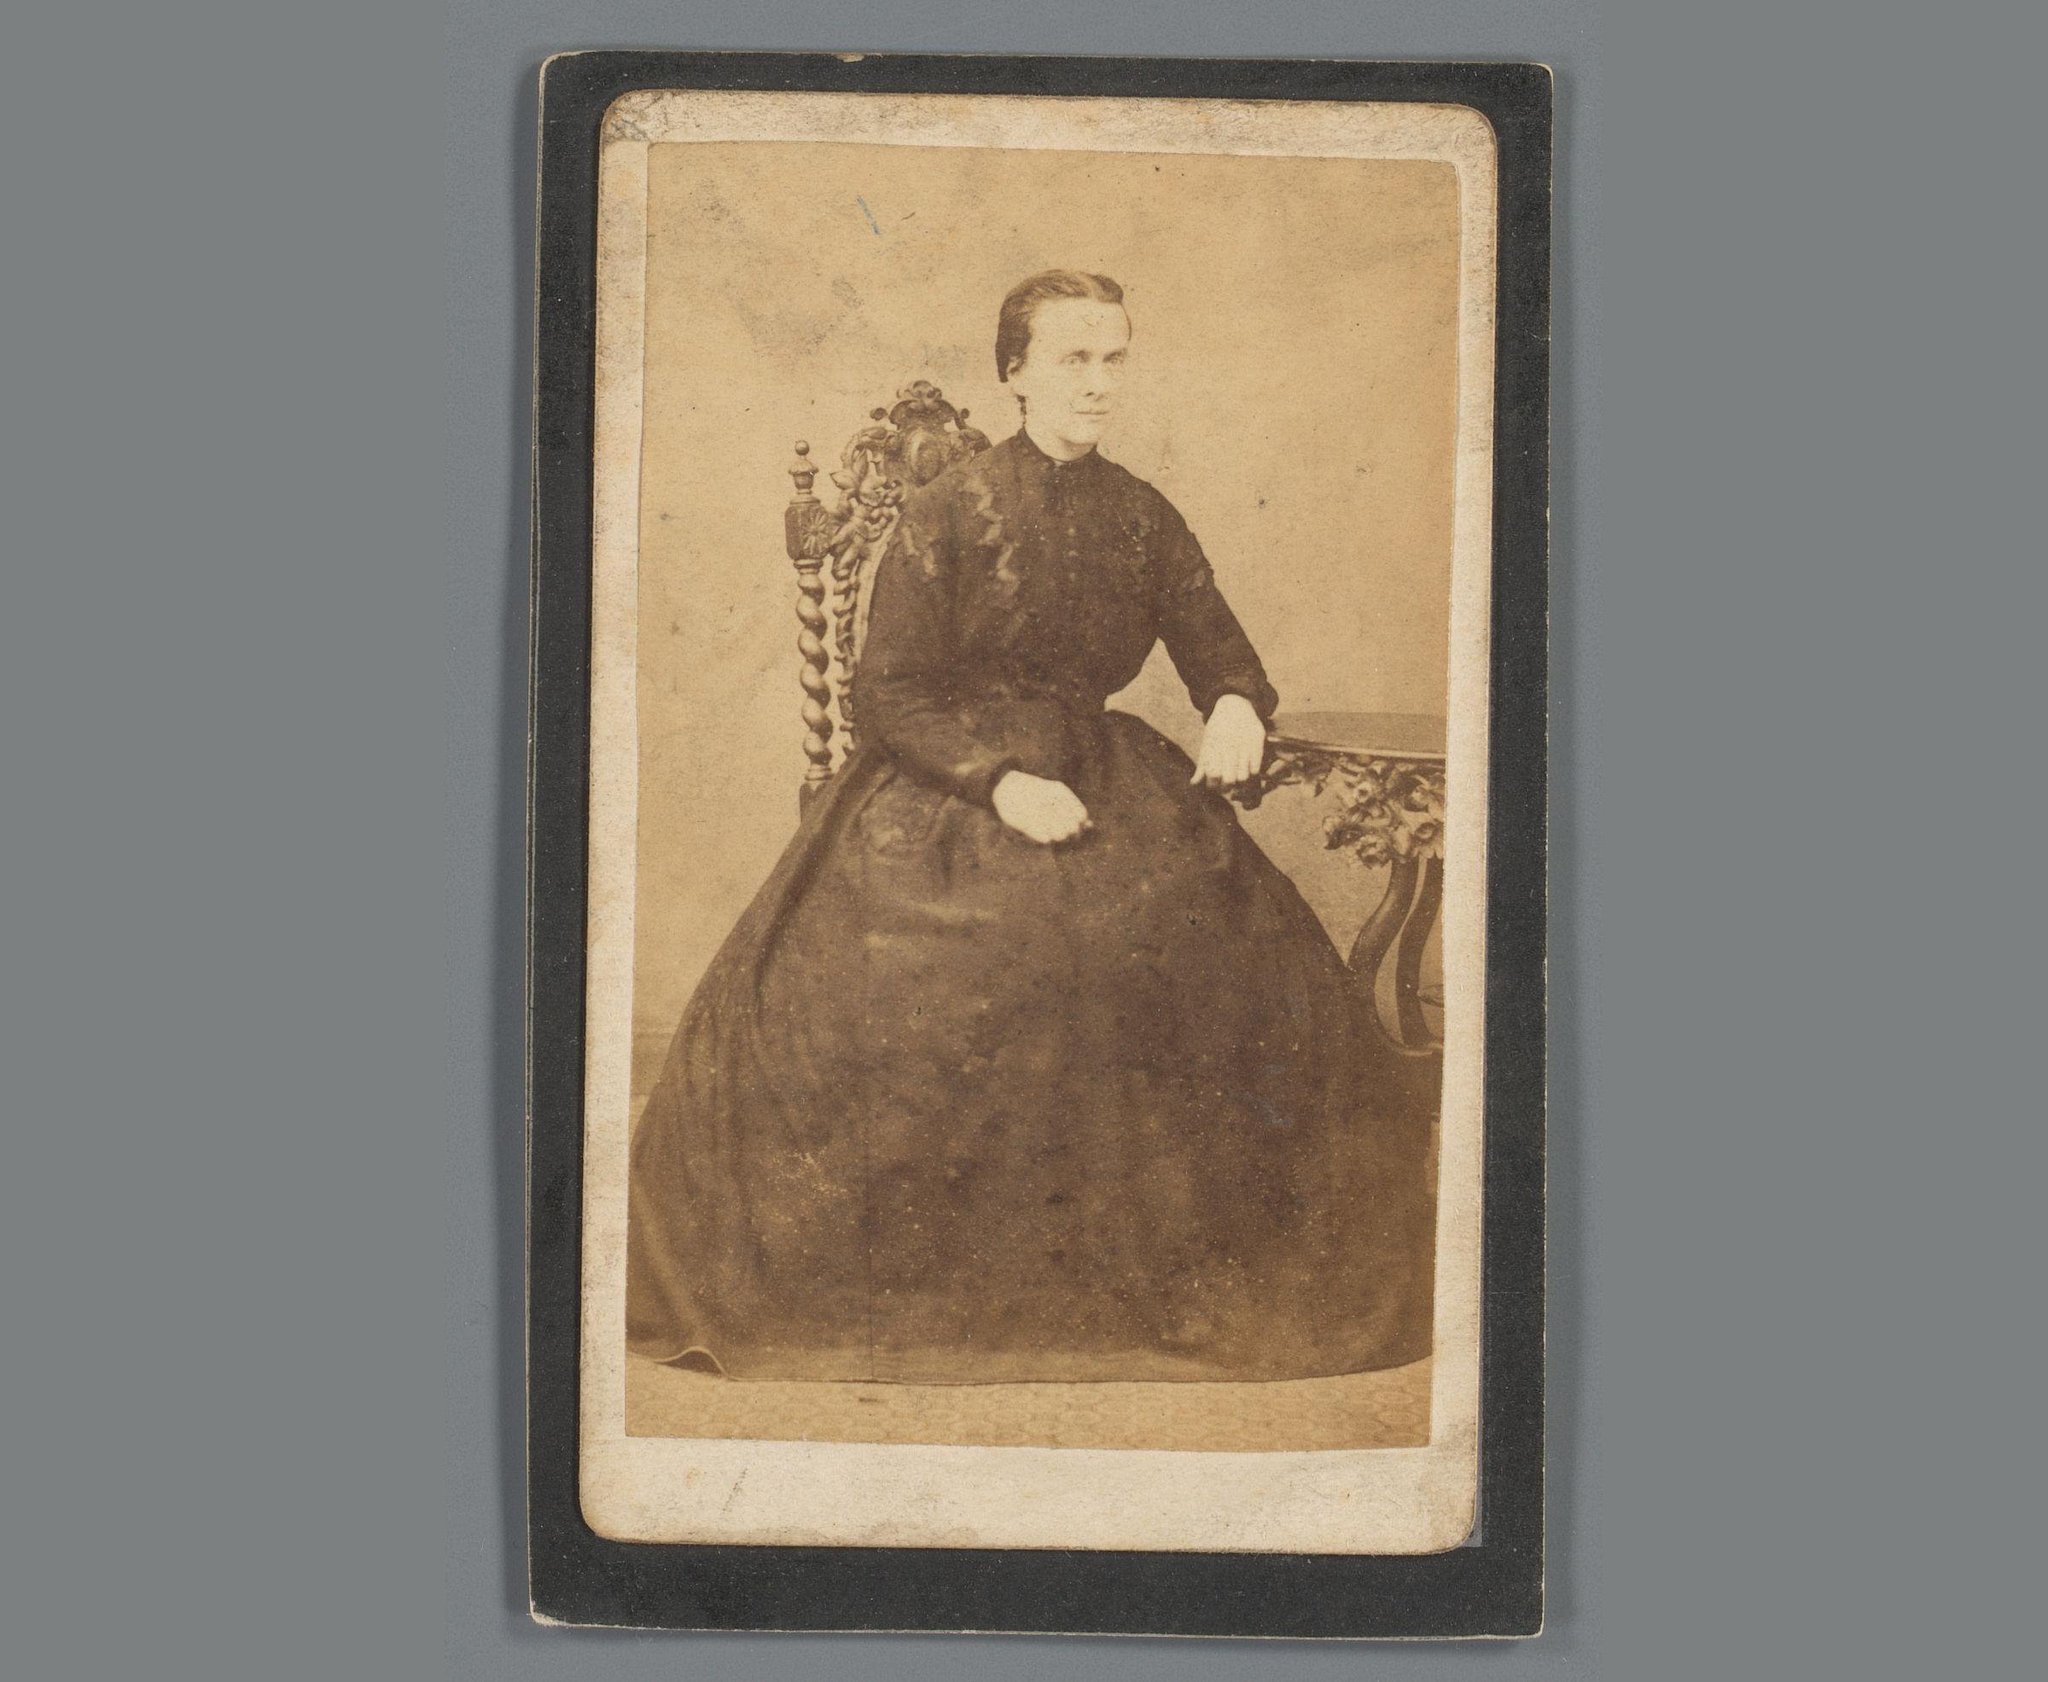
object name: prayer card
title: Portret van Clasina Christina Rietveld op bidprent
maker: Anonymous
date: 1900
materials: cardboard, paper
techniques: albumen print, letterpress printing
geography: amsterdam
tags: amsterdam, adult woman, historical persons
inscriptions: inscription: ‘Gedenk in uwe gebeden (...) Heer, geef haar de eeuwige rust./ Gez. de Veer. Prinsengracht 746 Amst.’